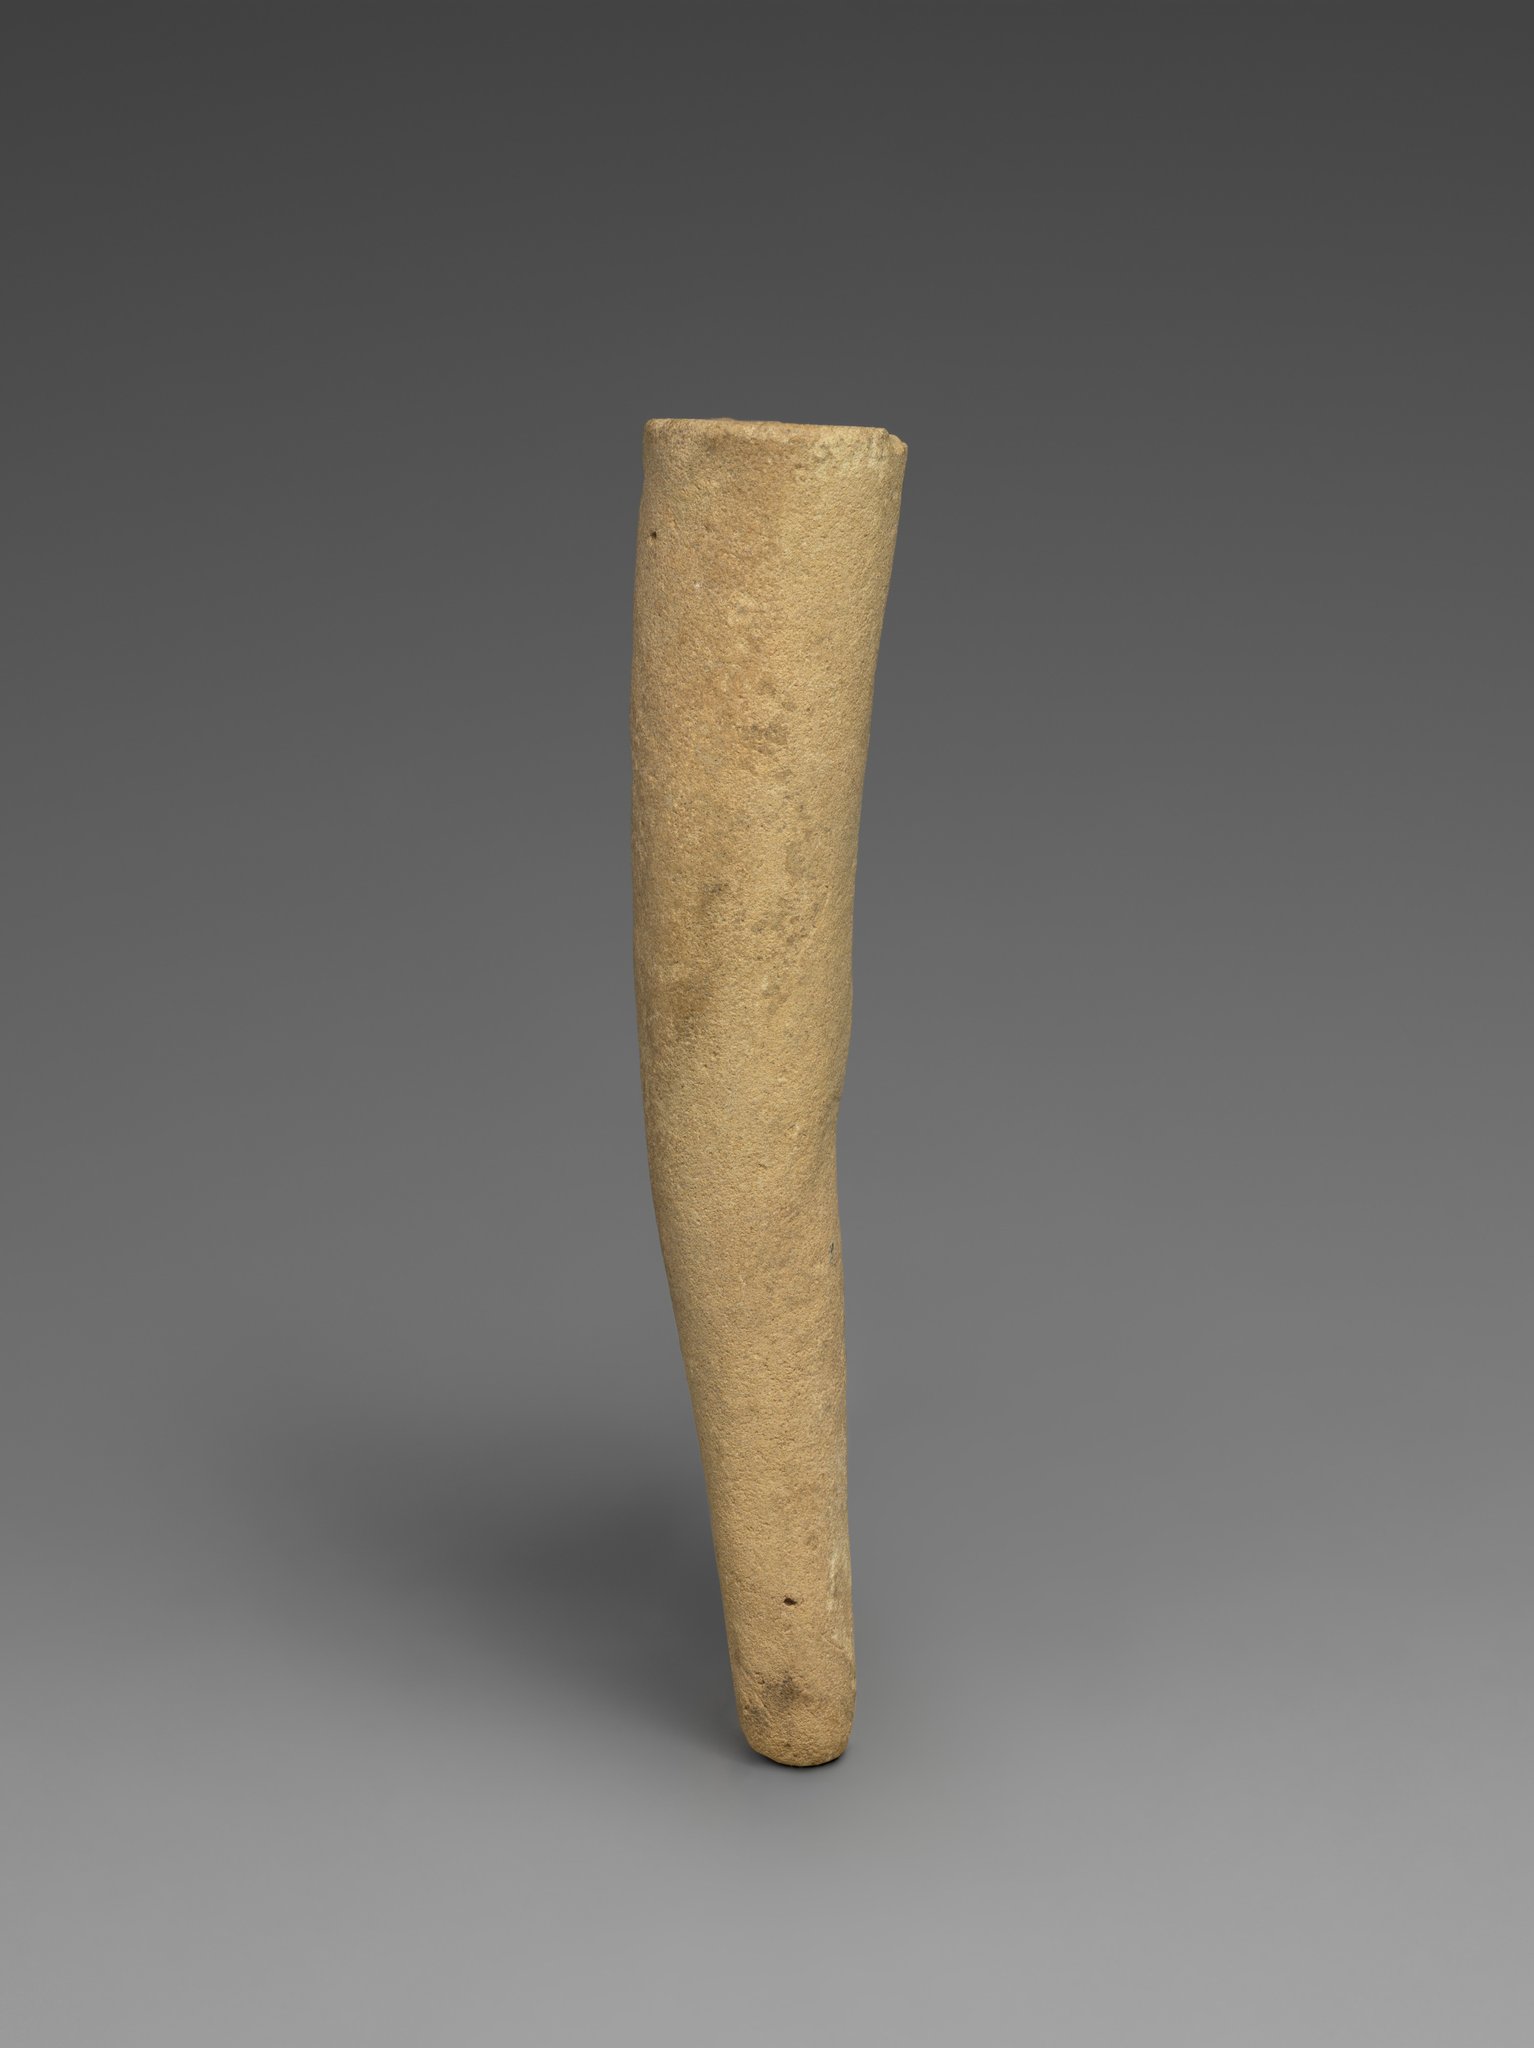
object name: mosaic cone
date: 3100-2900 BCE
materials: ceramic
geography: mesopotamia